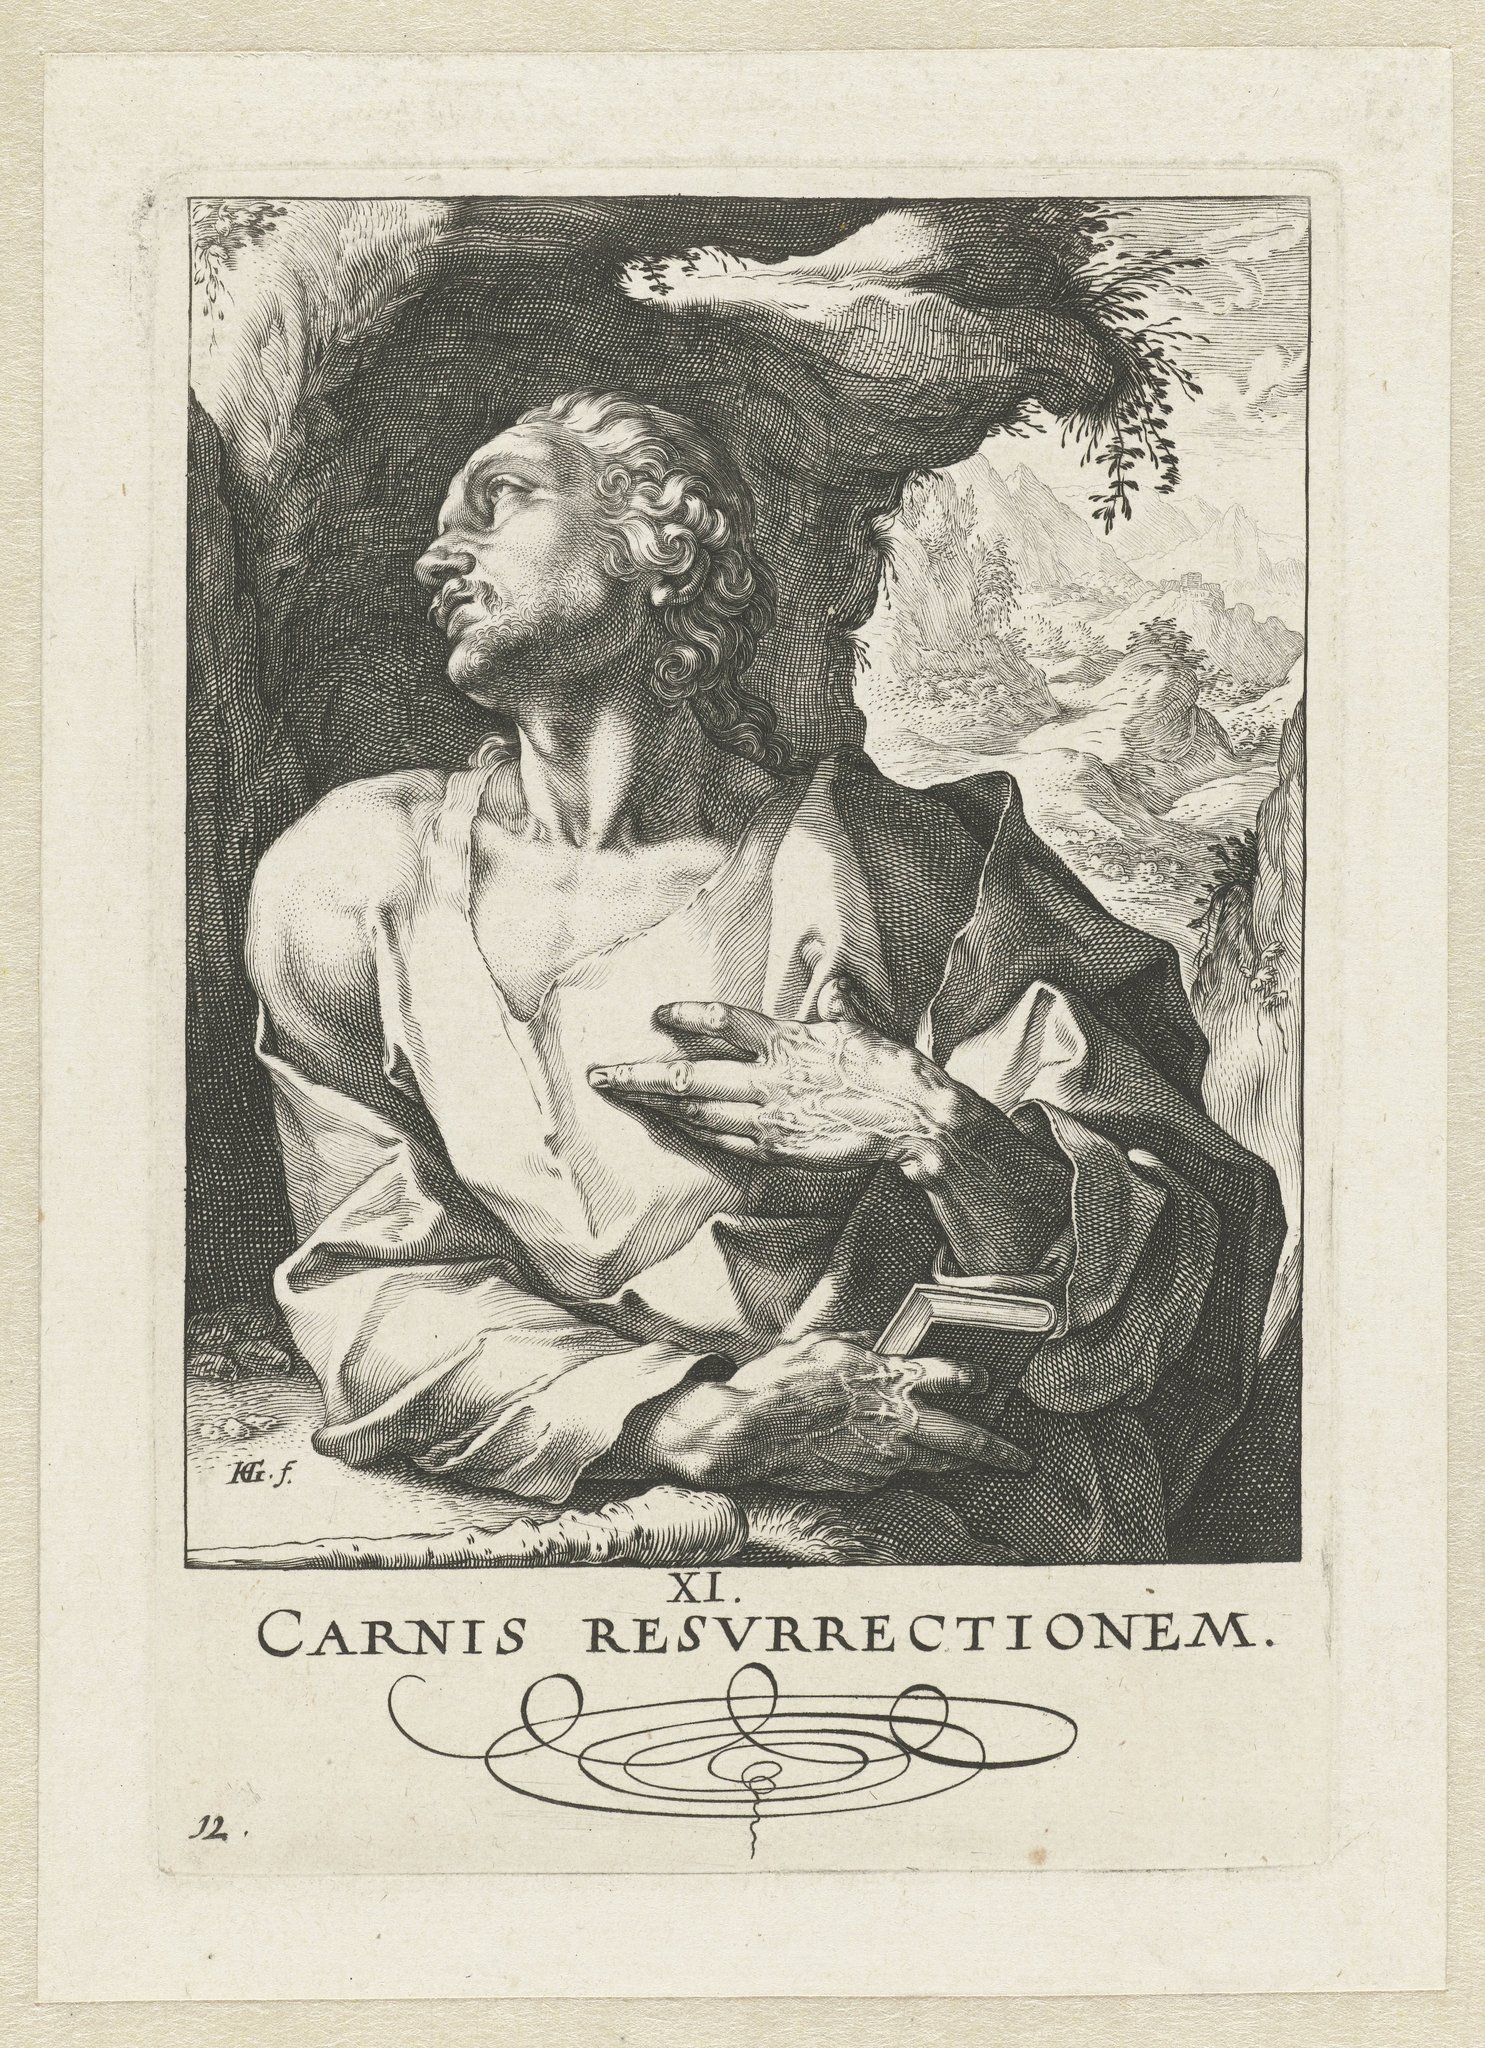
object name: print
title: Christus, de twaalf apostelen en de heilige Paulus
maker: hendrick goltzius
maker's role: draughtsman, painter, print maker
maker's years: 1558-1617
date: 1589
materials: paper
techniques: engraving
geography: haarlem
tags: the apostle jude thaddaeus; possible attributes: book, club, halberd, scroll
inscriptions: signature: ‘HG. f.’, collector's mark: Lugt 240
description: De heilige Judas Thaddeüs ten halven lijve, een knots voor zich. In marge onder de prent een regel Latijn. Prent uit een serie van veertien.